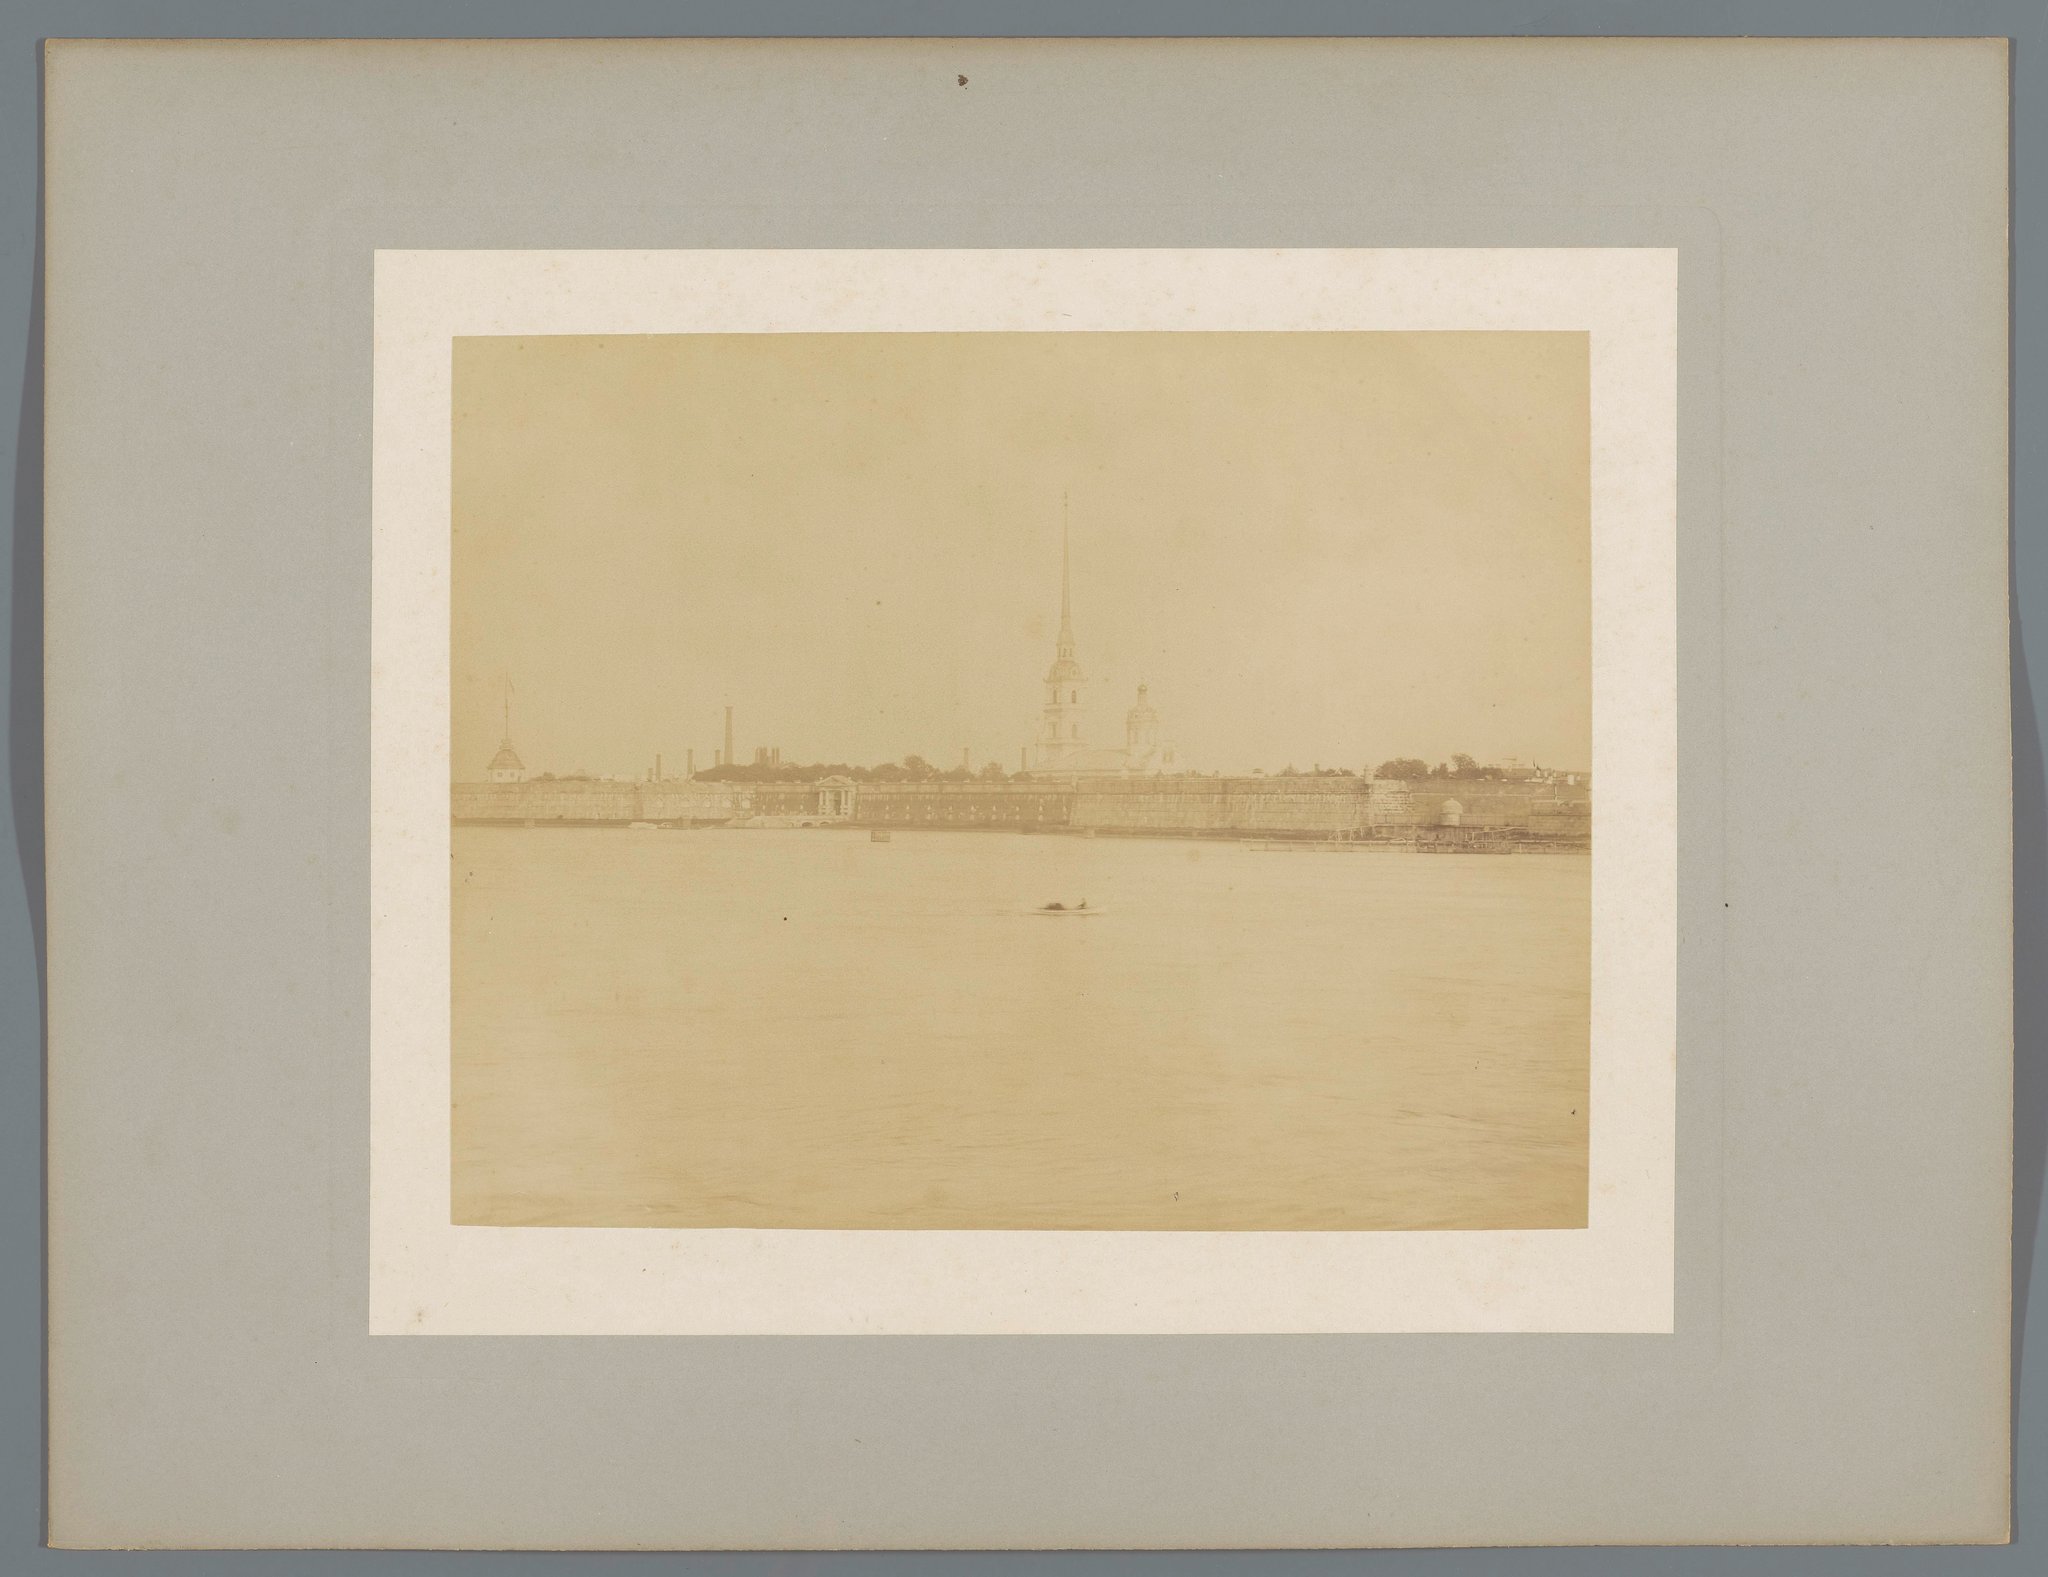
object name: photograph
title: Gezicht op de Petrus-en-Paulusvesting aan de Neva, in het midden de Petrus-en-Pauluskathedraal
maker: Anonymous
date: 1860-1890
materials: cardboard, paper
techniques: albumen print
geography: sint-petersburg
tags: fortress, russian orthodox church